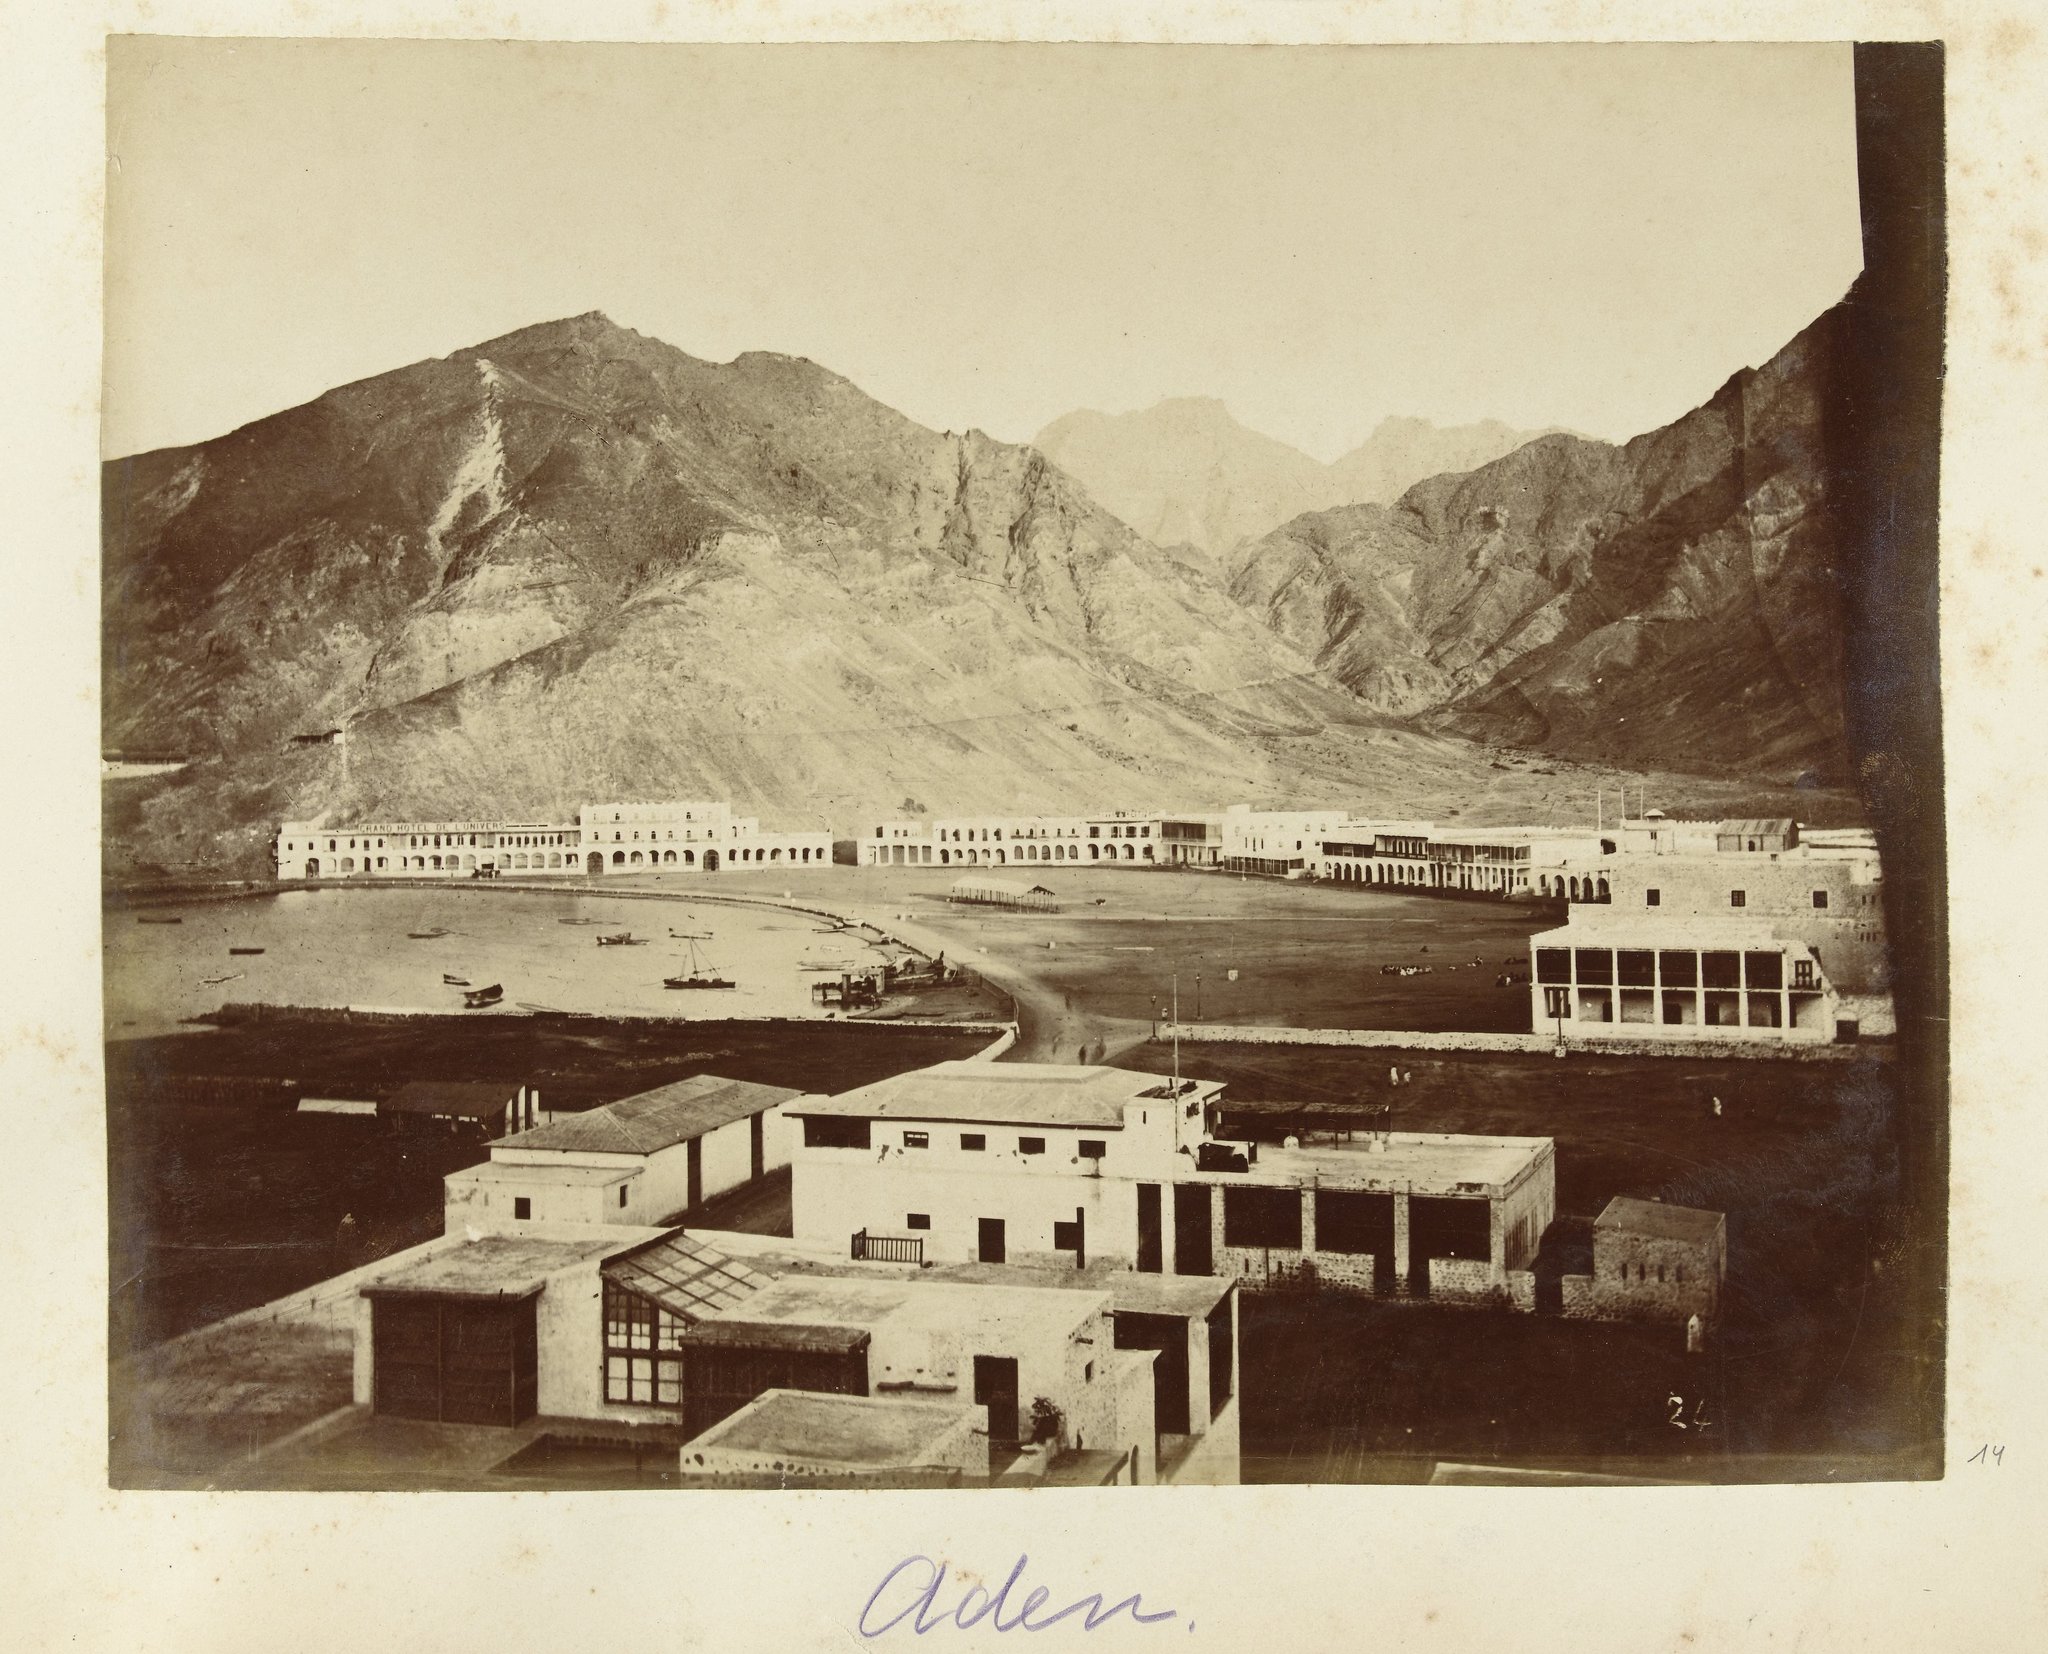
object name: photograph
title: Aden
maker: Anonymous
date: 1890-1910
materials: cardboard, paper, photographic support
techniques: gelatin silver print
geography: netherlands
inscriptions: caption: ‘Aden’